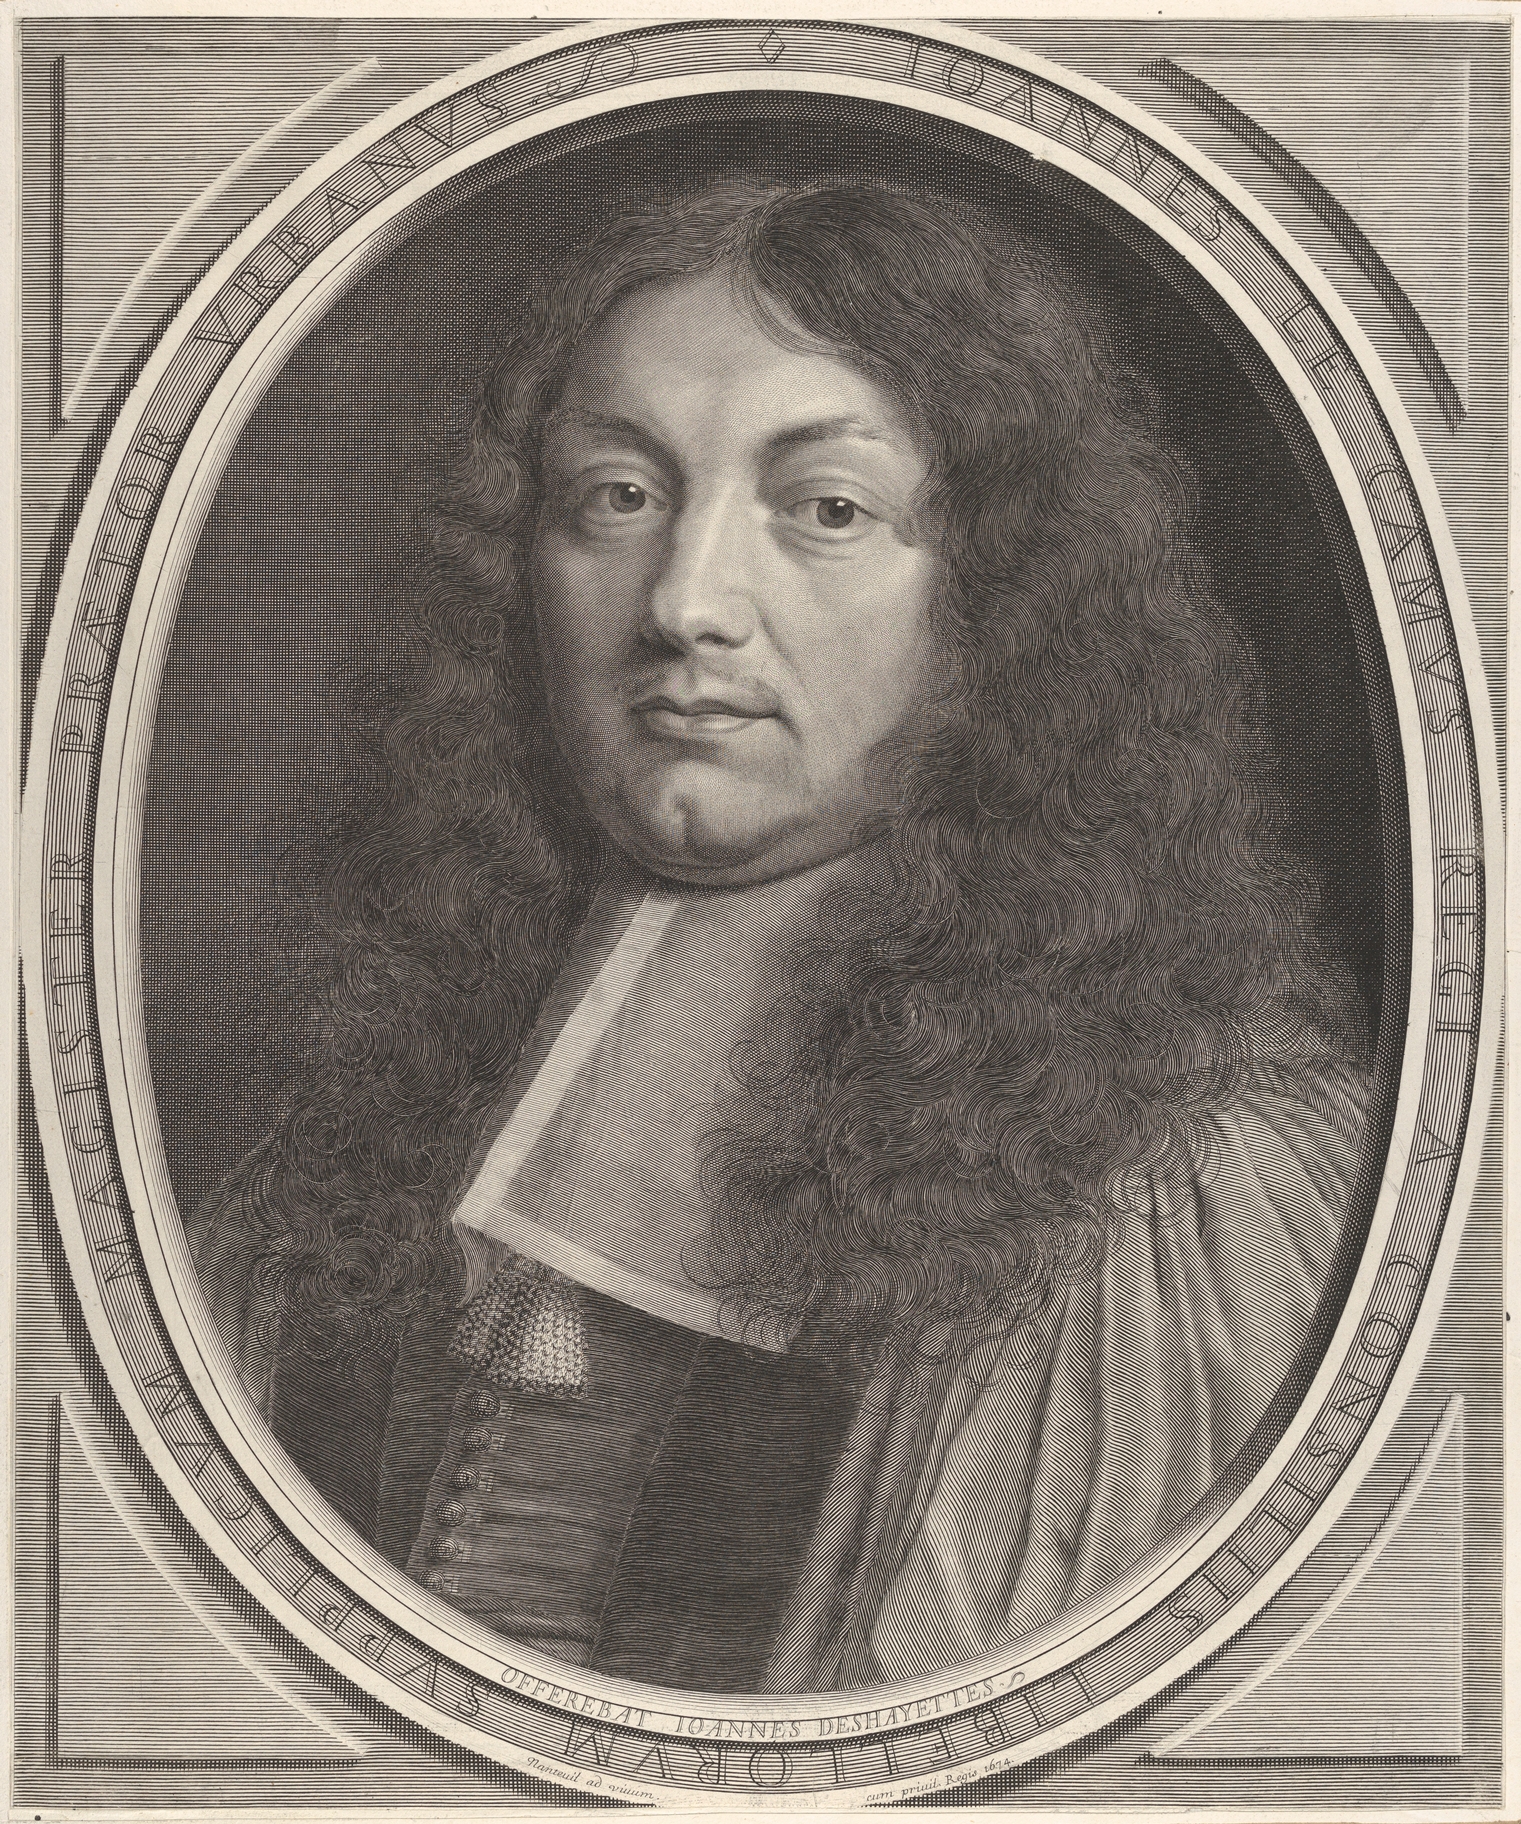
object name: print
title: Jean Le Camus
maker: robert nanteuil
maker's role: artist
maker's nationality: french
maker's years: 1623-1678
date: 1674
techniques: engraving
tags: men,portraits